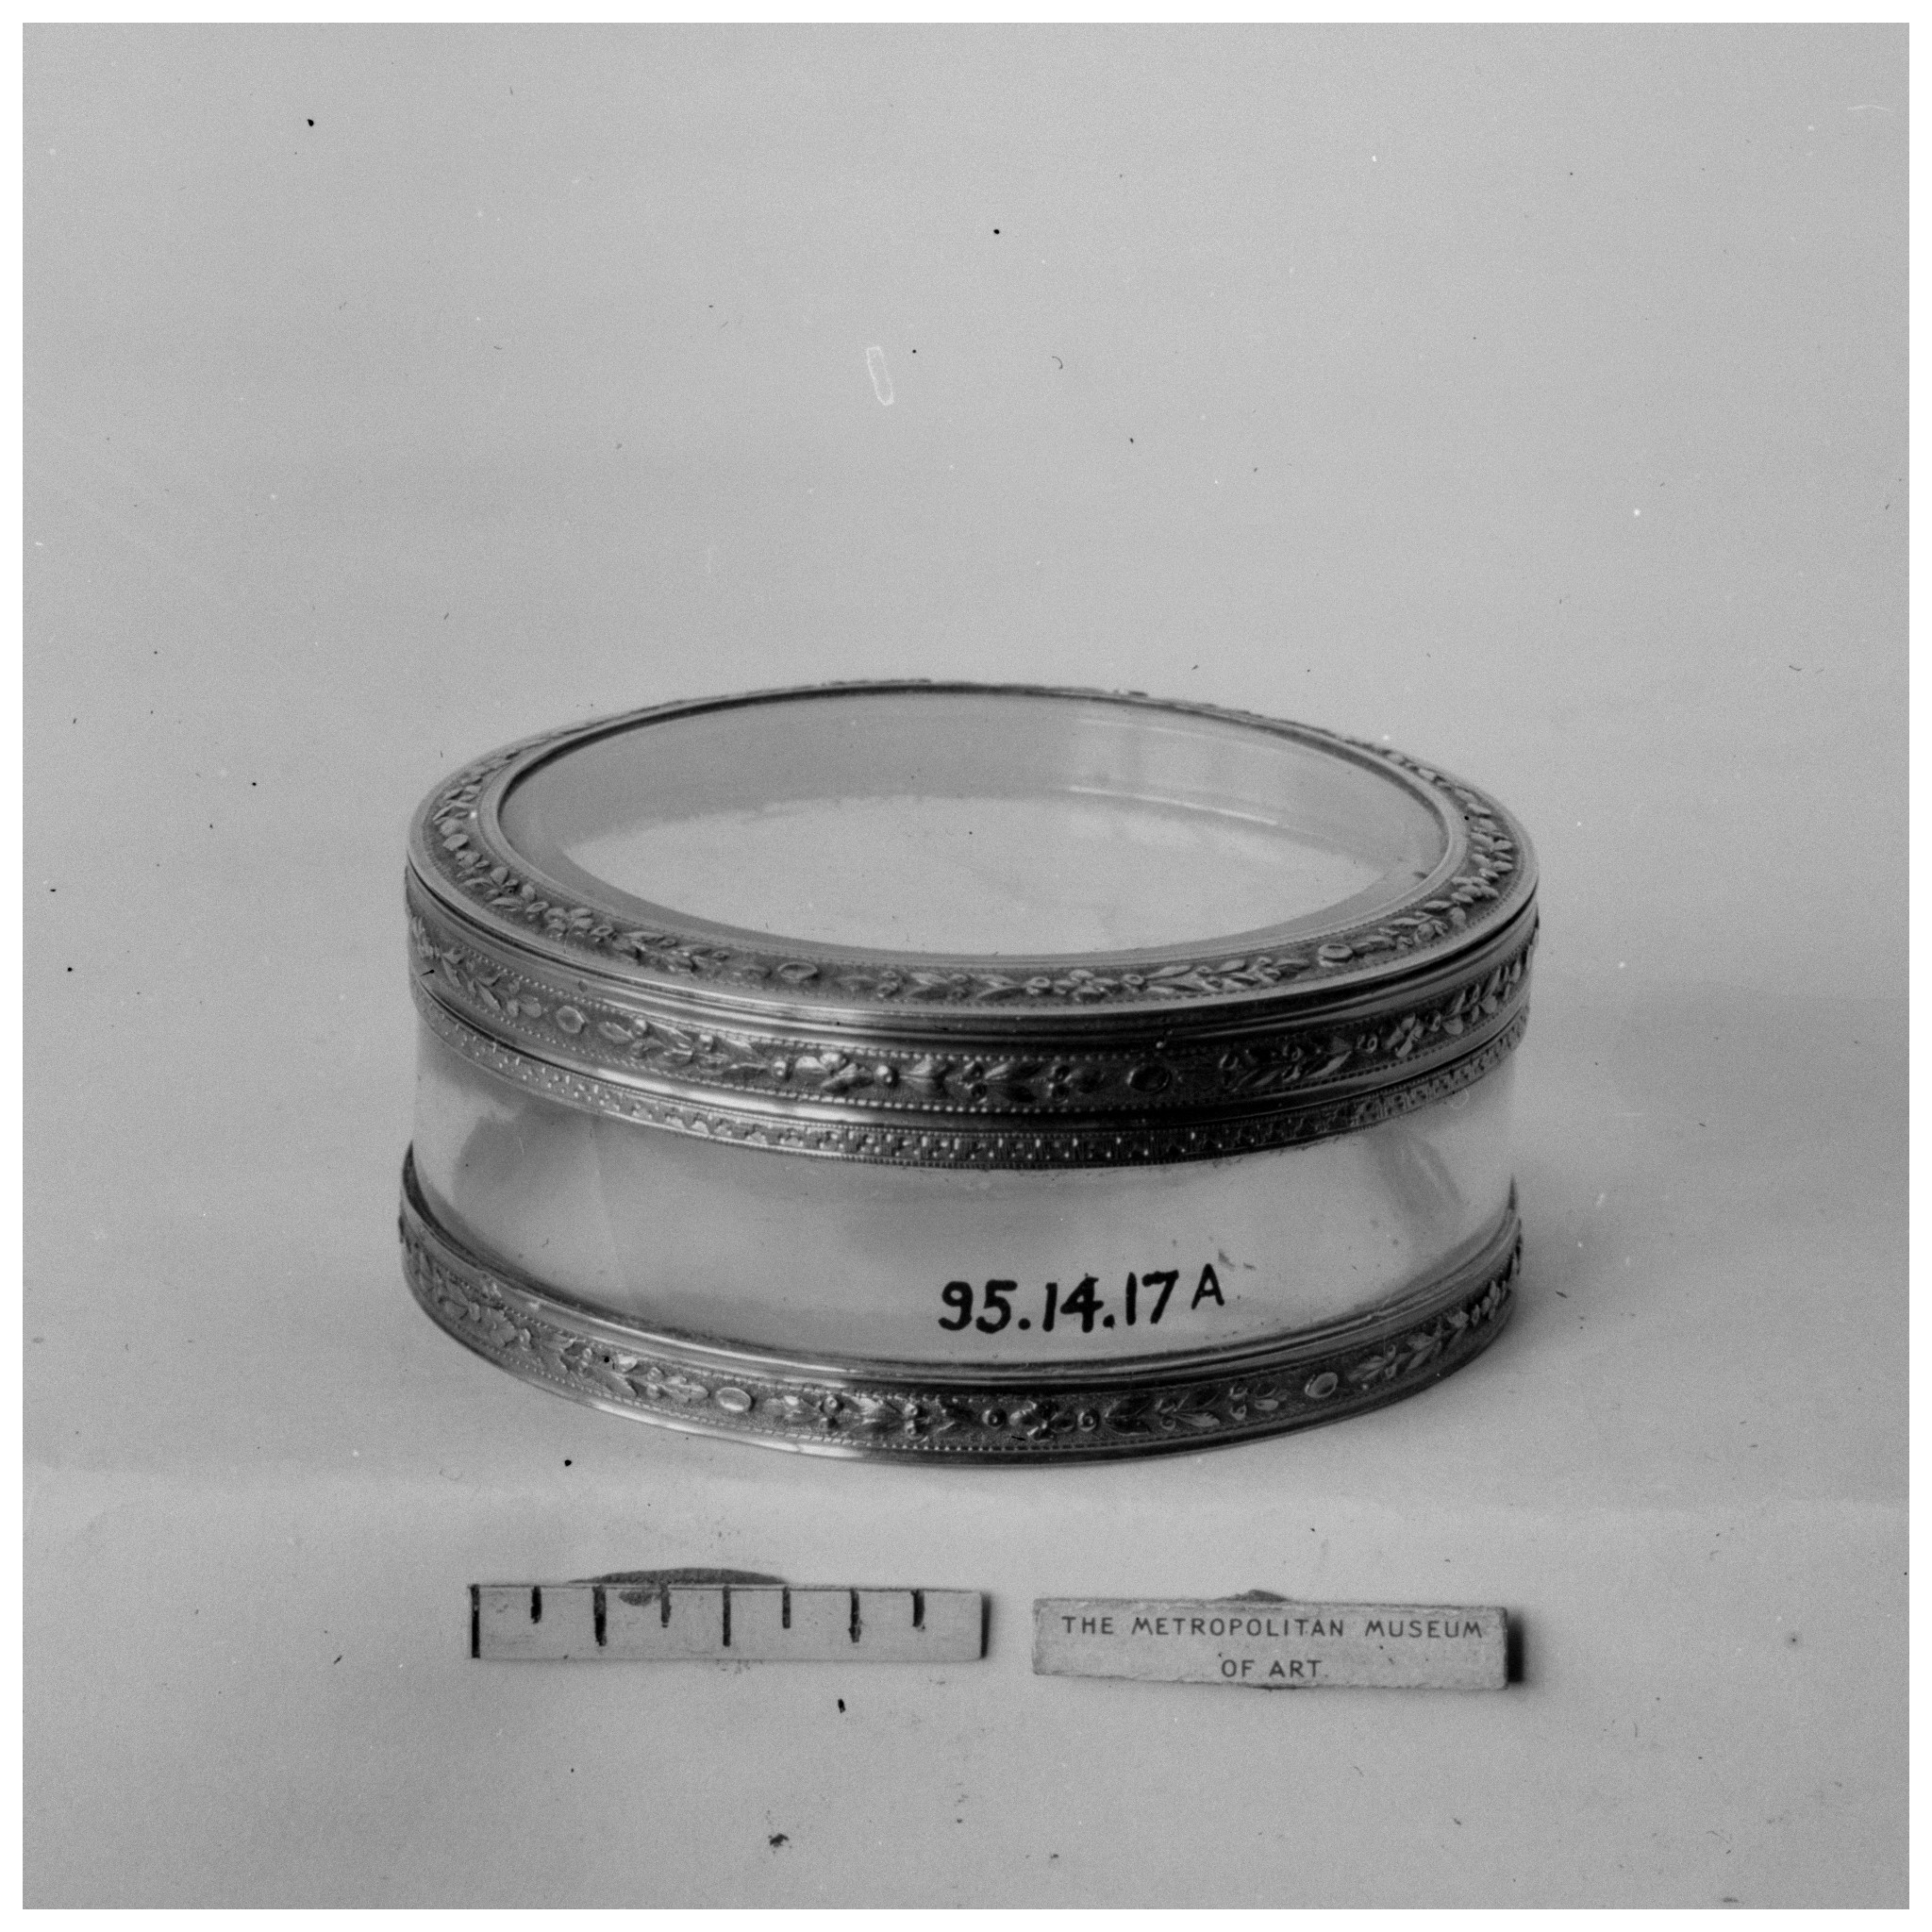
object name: box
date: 1787-1788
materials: crystal, gold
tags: garlands